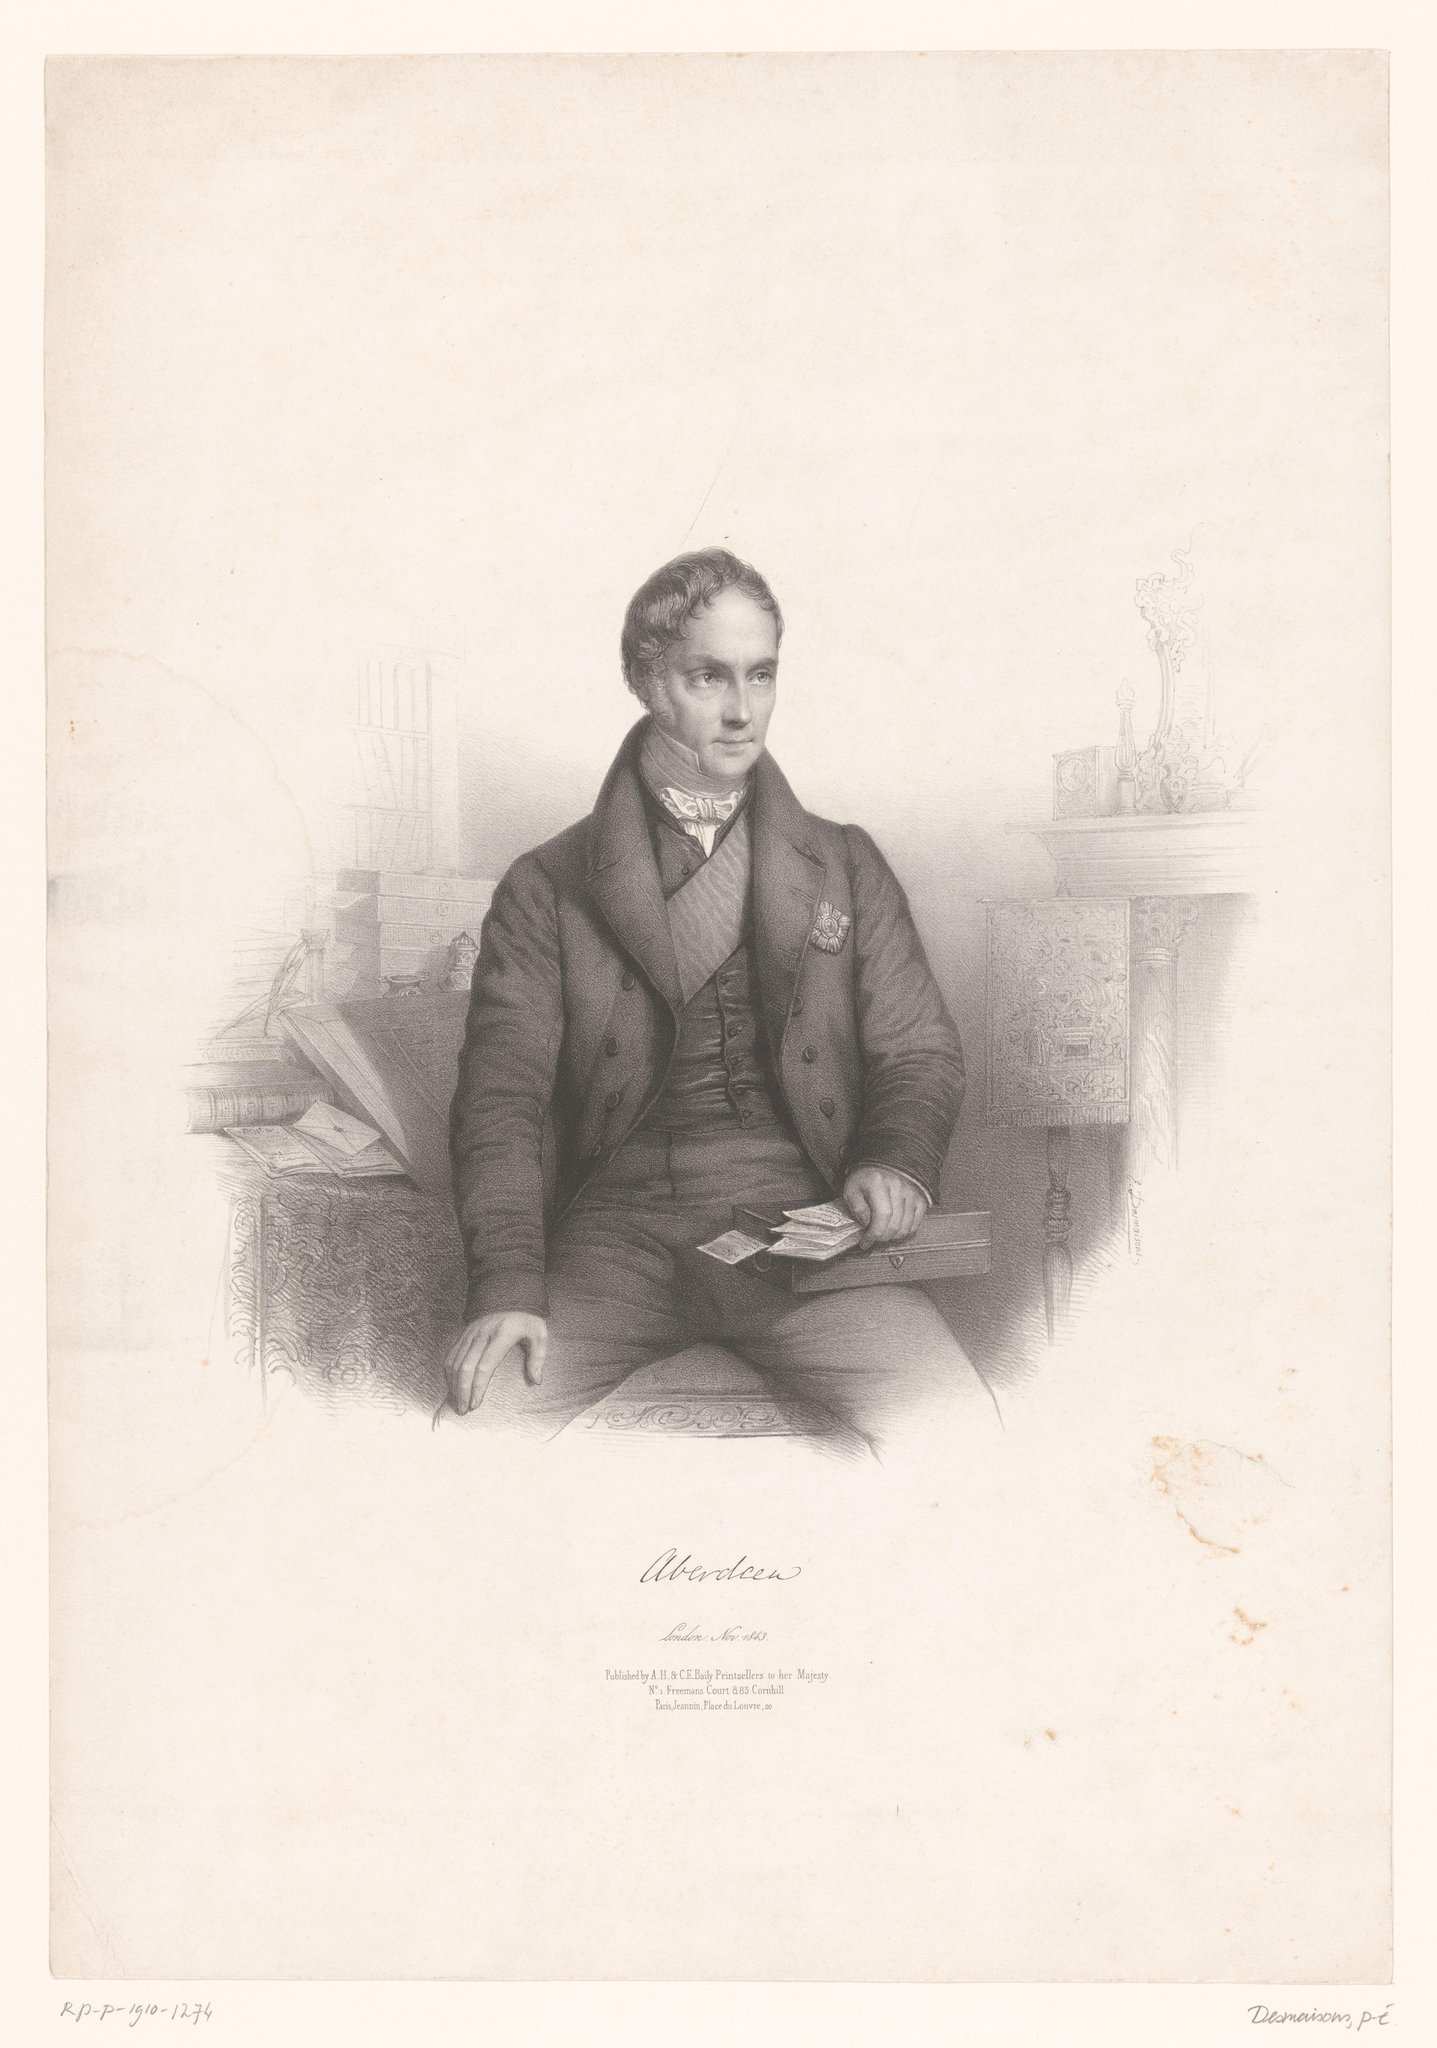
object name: print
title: Portretten van Engelsen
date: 1843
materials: paper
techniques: lithograph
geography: london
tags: london, politician, historical persons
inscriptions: collector's mark: Lugt 2228a